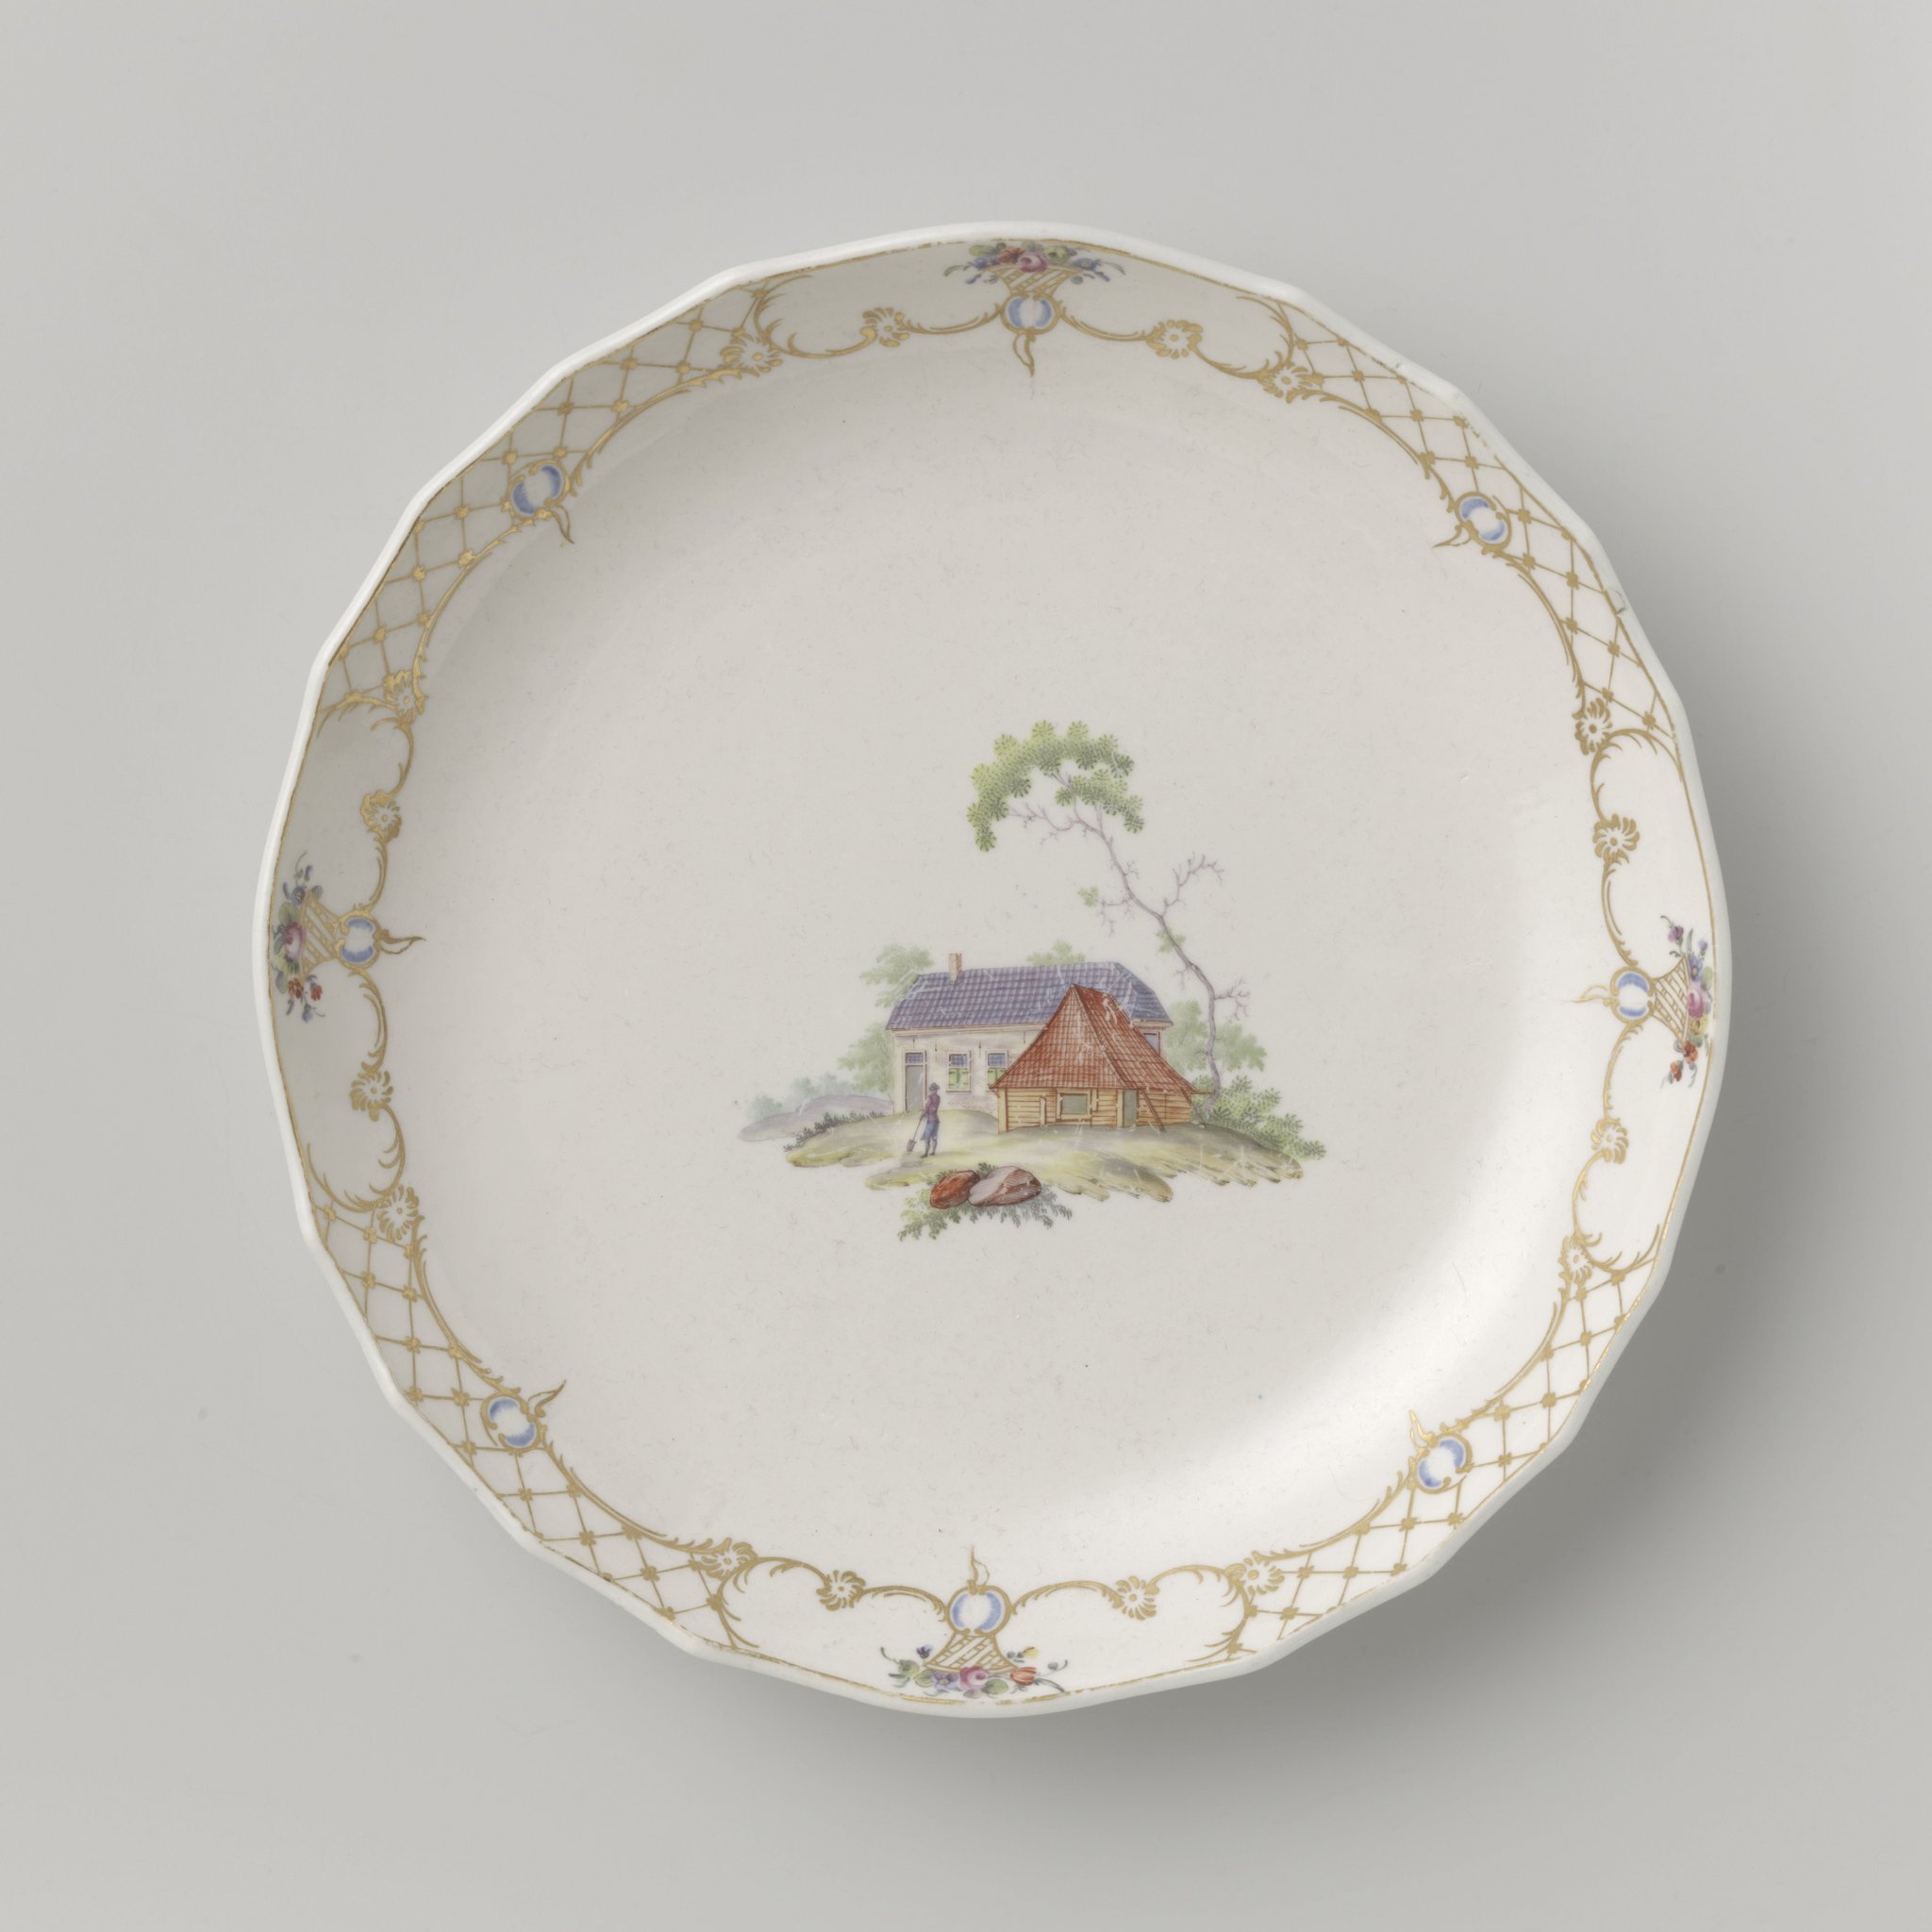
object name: platter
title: Schotel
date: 1777-1790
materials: porcelain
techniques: painted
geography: the hague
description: Soft-paste porcelain decorated in the factory of Anton Lyncker or his heirs at The Hague. Plate. Tournai, decorated in The Hague, c. 1777 - 1790.